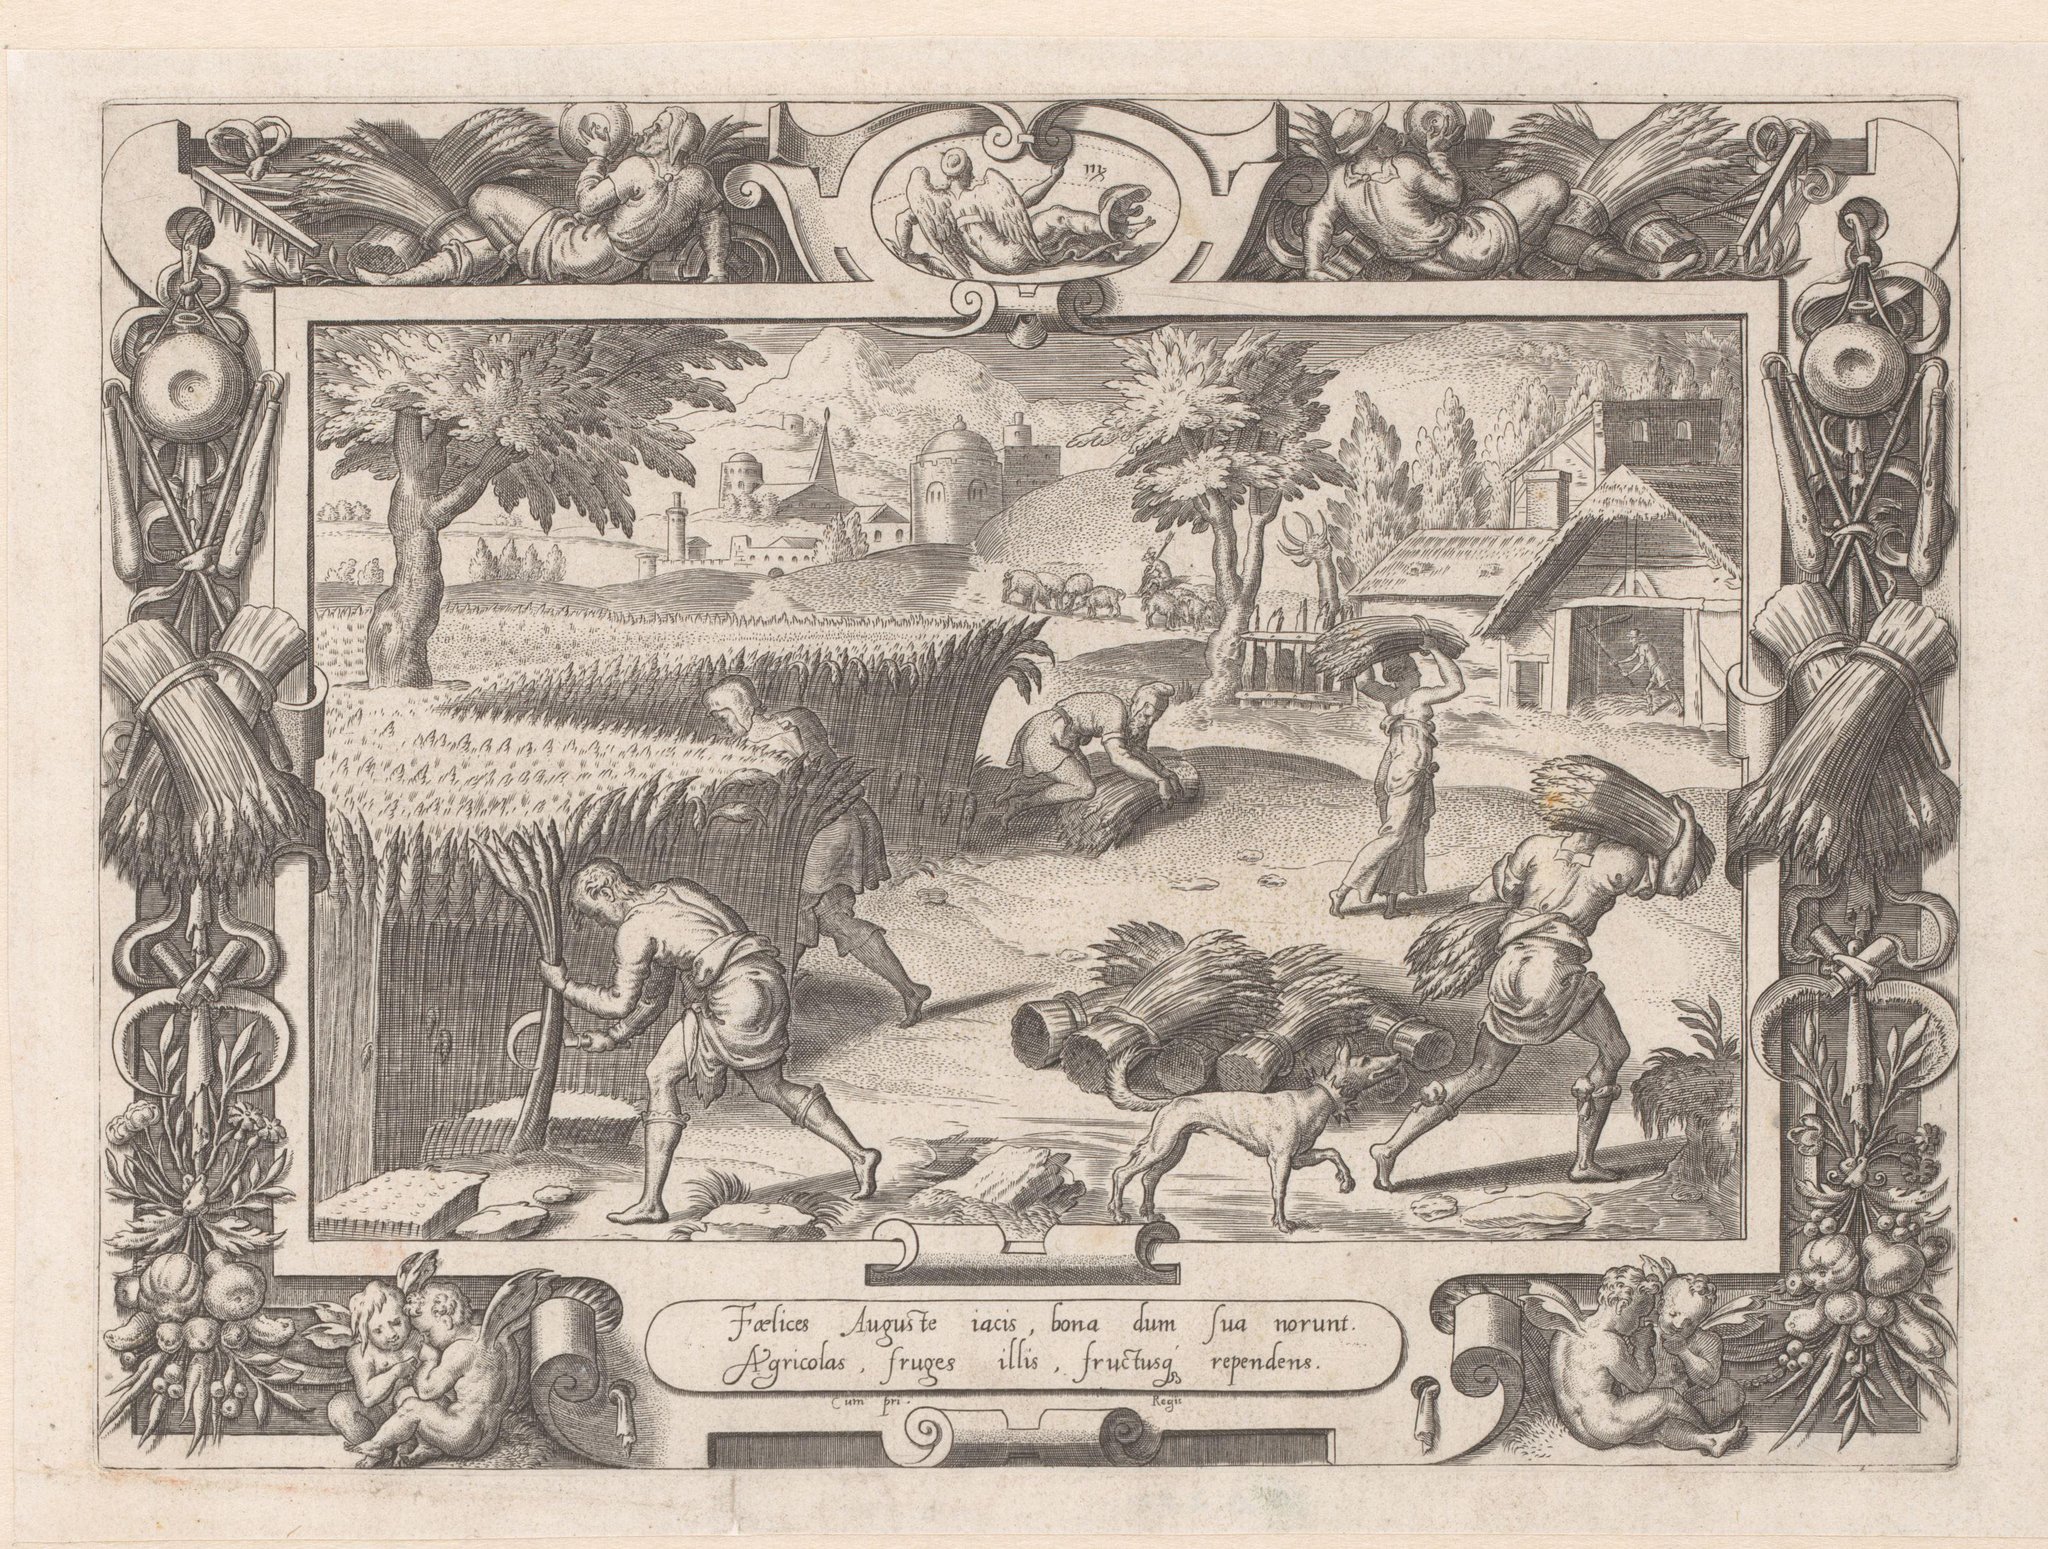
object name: print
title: Twaalf maanden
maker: etienne delaune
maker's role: draughtsman, goldsmith, print maker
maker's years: 1519-1583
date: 1566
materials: paper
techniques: engraving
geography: france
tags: virgo (zodiacal sign of august), harvest, fruits: gourd, sheaf, august and its 'labours' (+ with zodiacal signs)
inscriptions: collector's mark: Lugt 2228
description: Maakt deel uit van een twaalfdelige serie van de twaalf maanden in ornamentele lijsten met corresponderende motieven en tekens van de dierenriem. Januari, met het hoofd van Janus, vormt de enige uitzondering. In de collectie van het Rijksmuseum bevindt zich de complete serie.